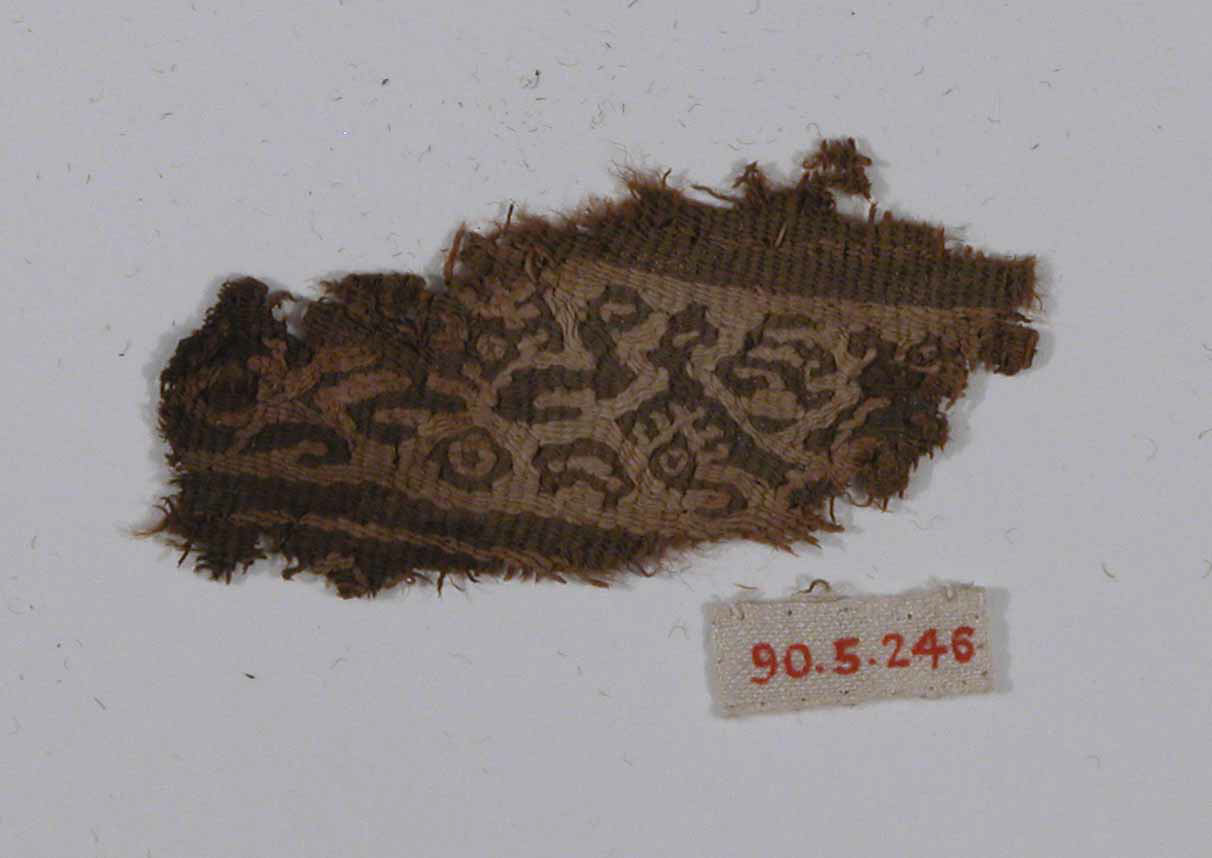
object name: textile fragment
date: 401-600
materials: linen, wool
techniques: weave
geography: egypt